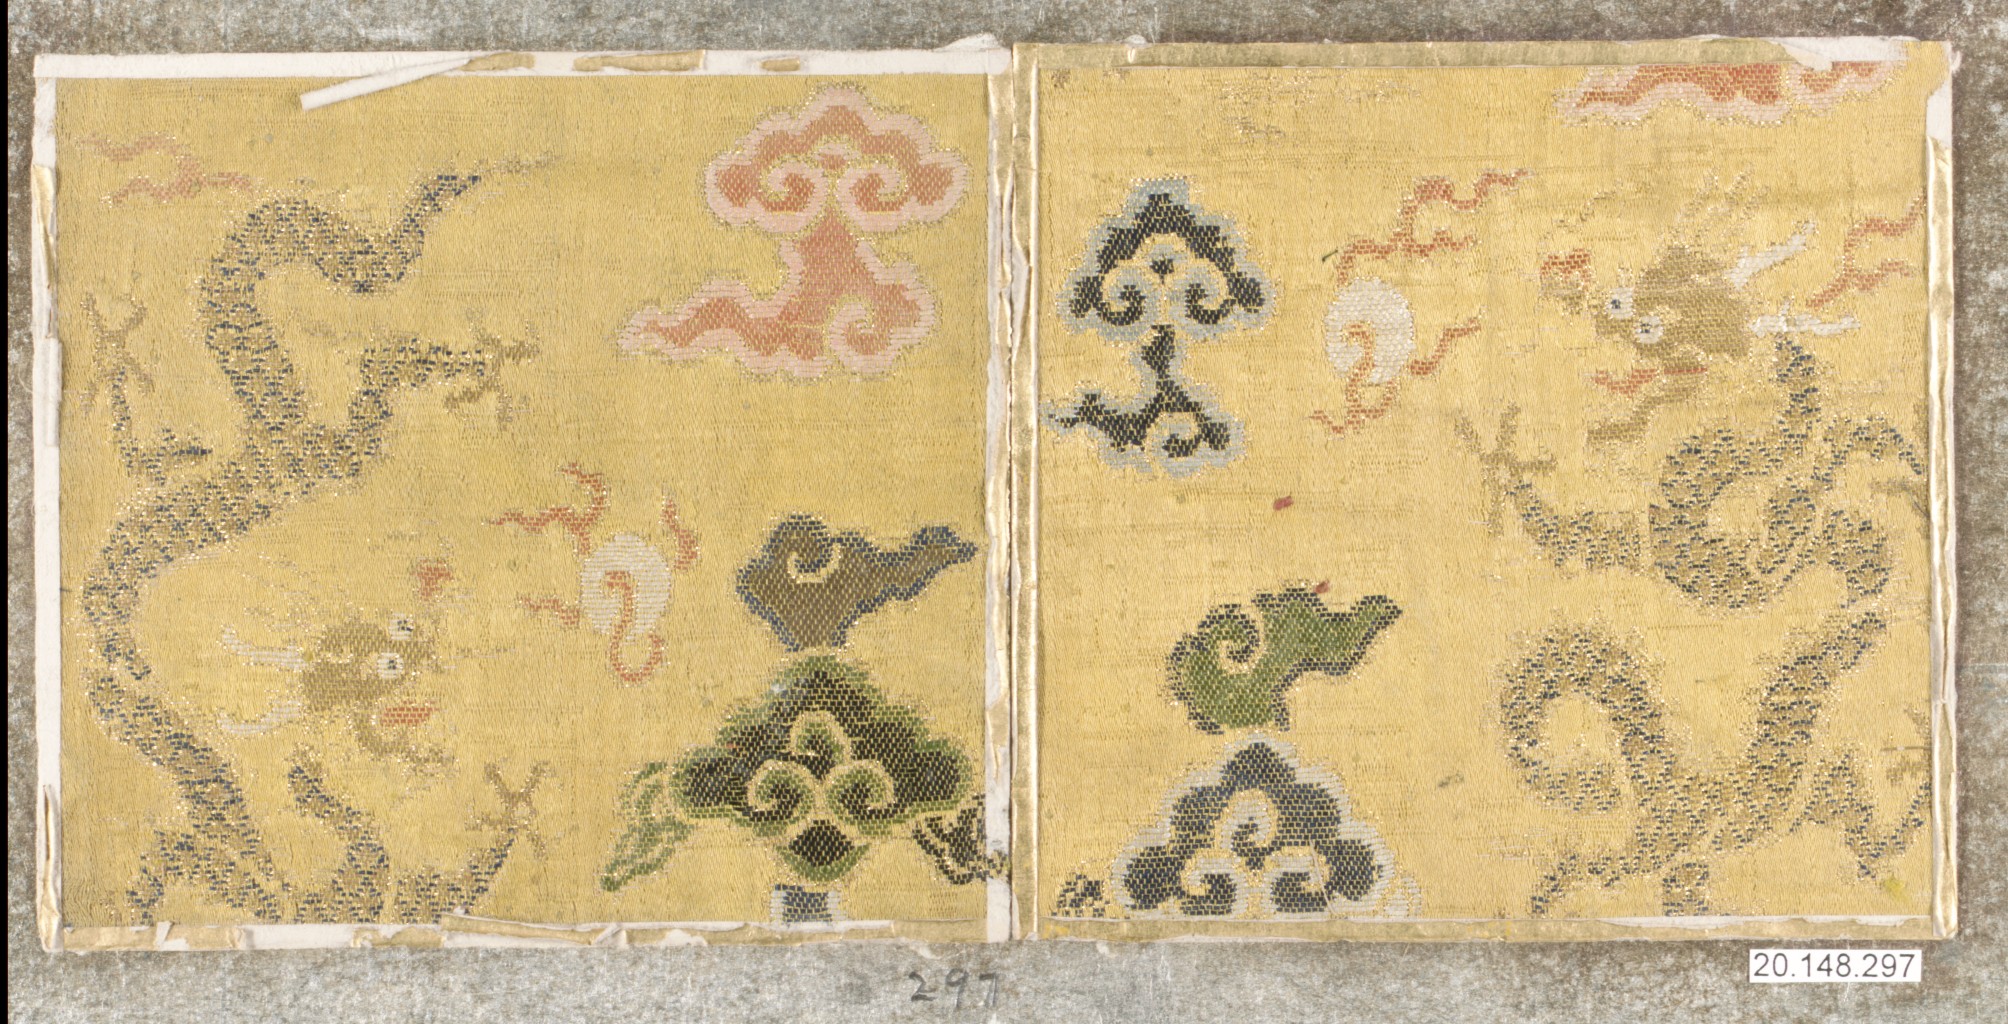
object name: brocade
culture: china or japan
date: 1601-1700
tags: dragons